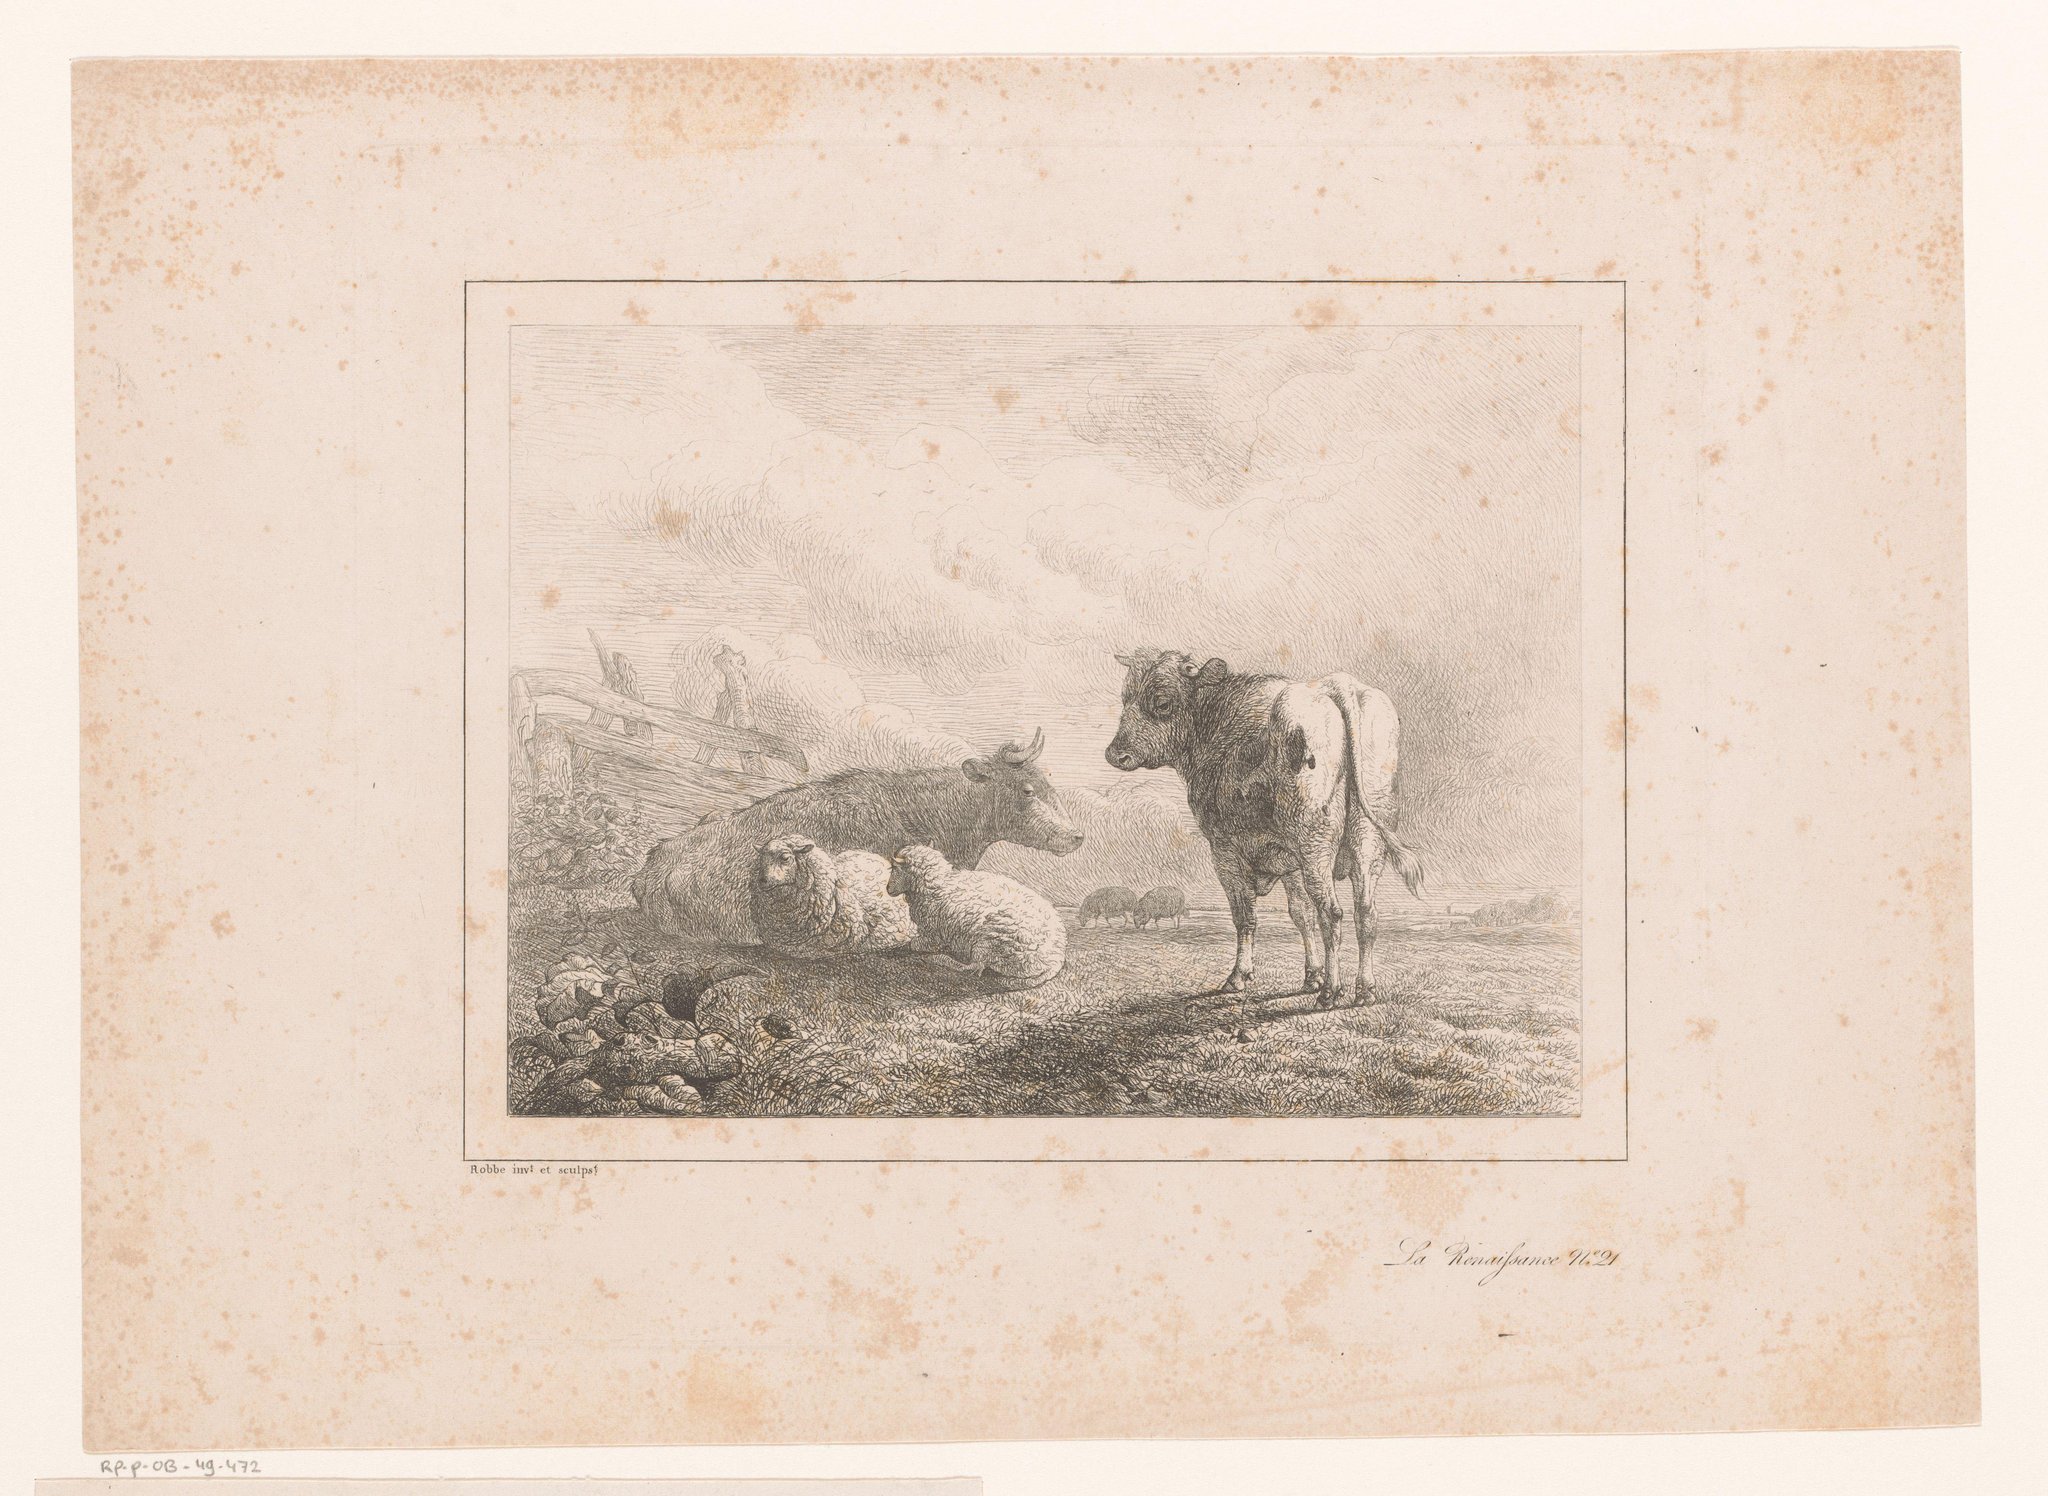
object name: print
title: Landschap met vee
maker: louis robbe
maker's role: print maker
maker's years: 1806-1887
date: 1839-1879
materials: paper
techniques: etching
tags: cattle, meadow, pasture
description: Prent uit een uitgave van: La Renaissance. Chronique des arts et de la littérature [1839-1849], pl. 21.